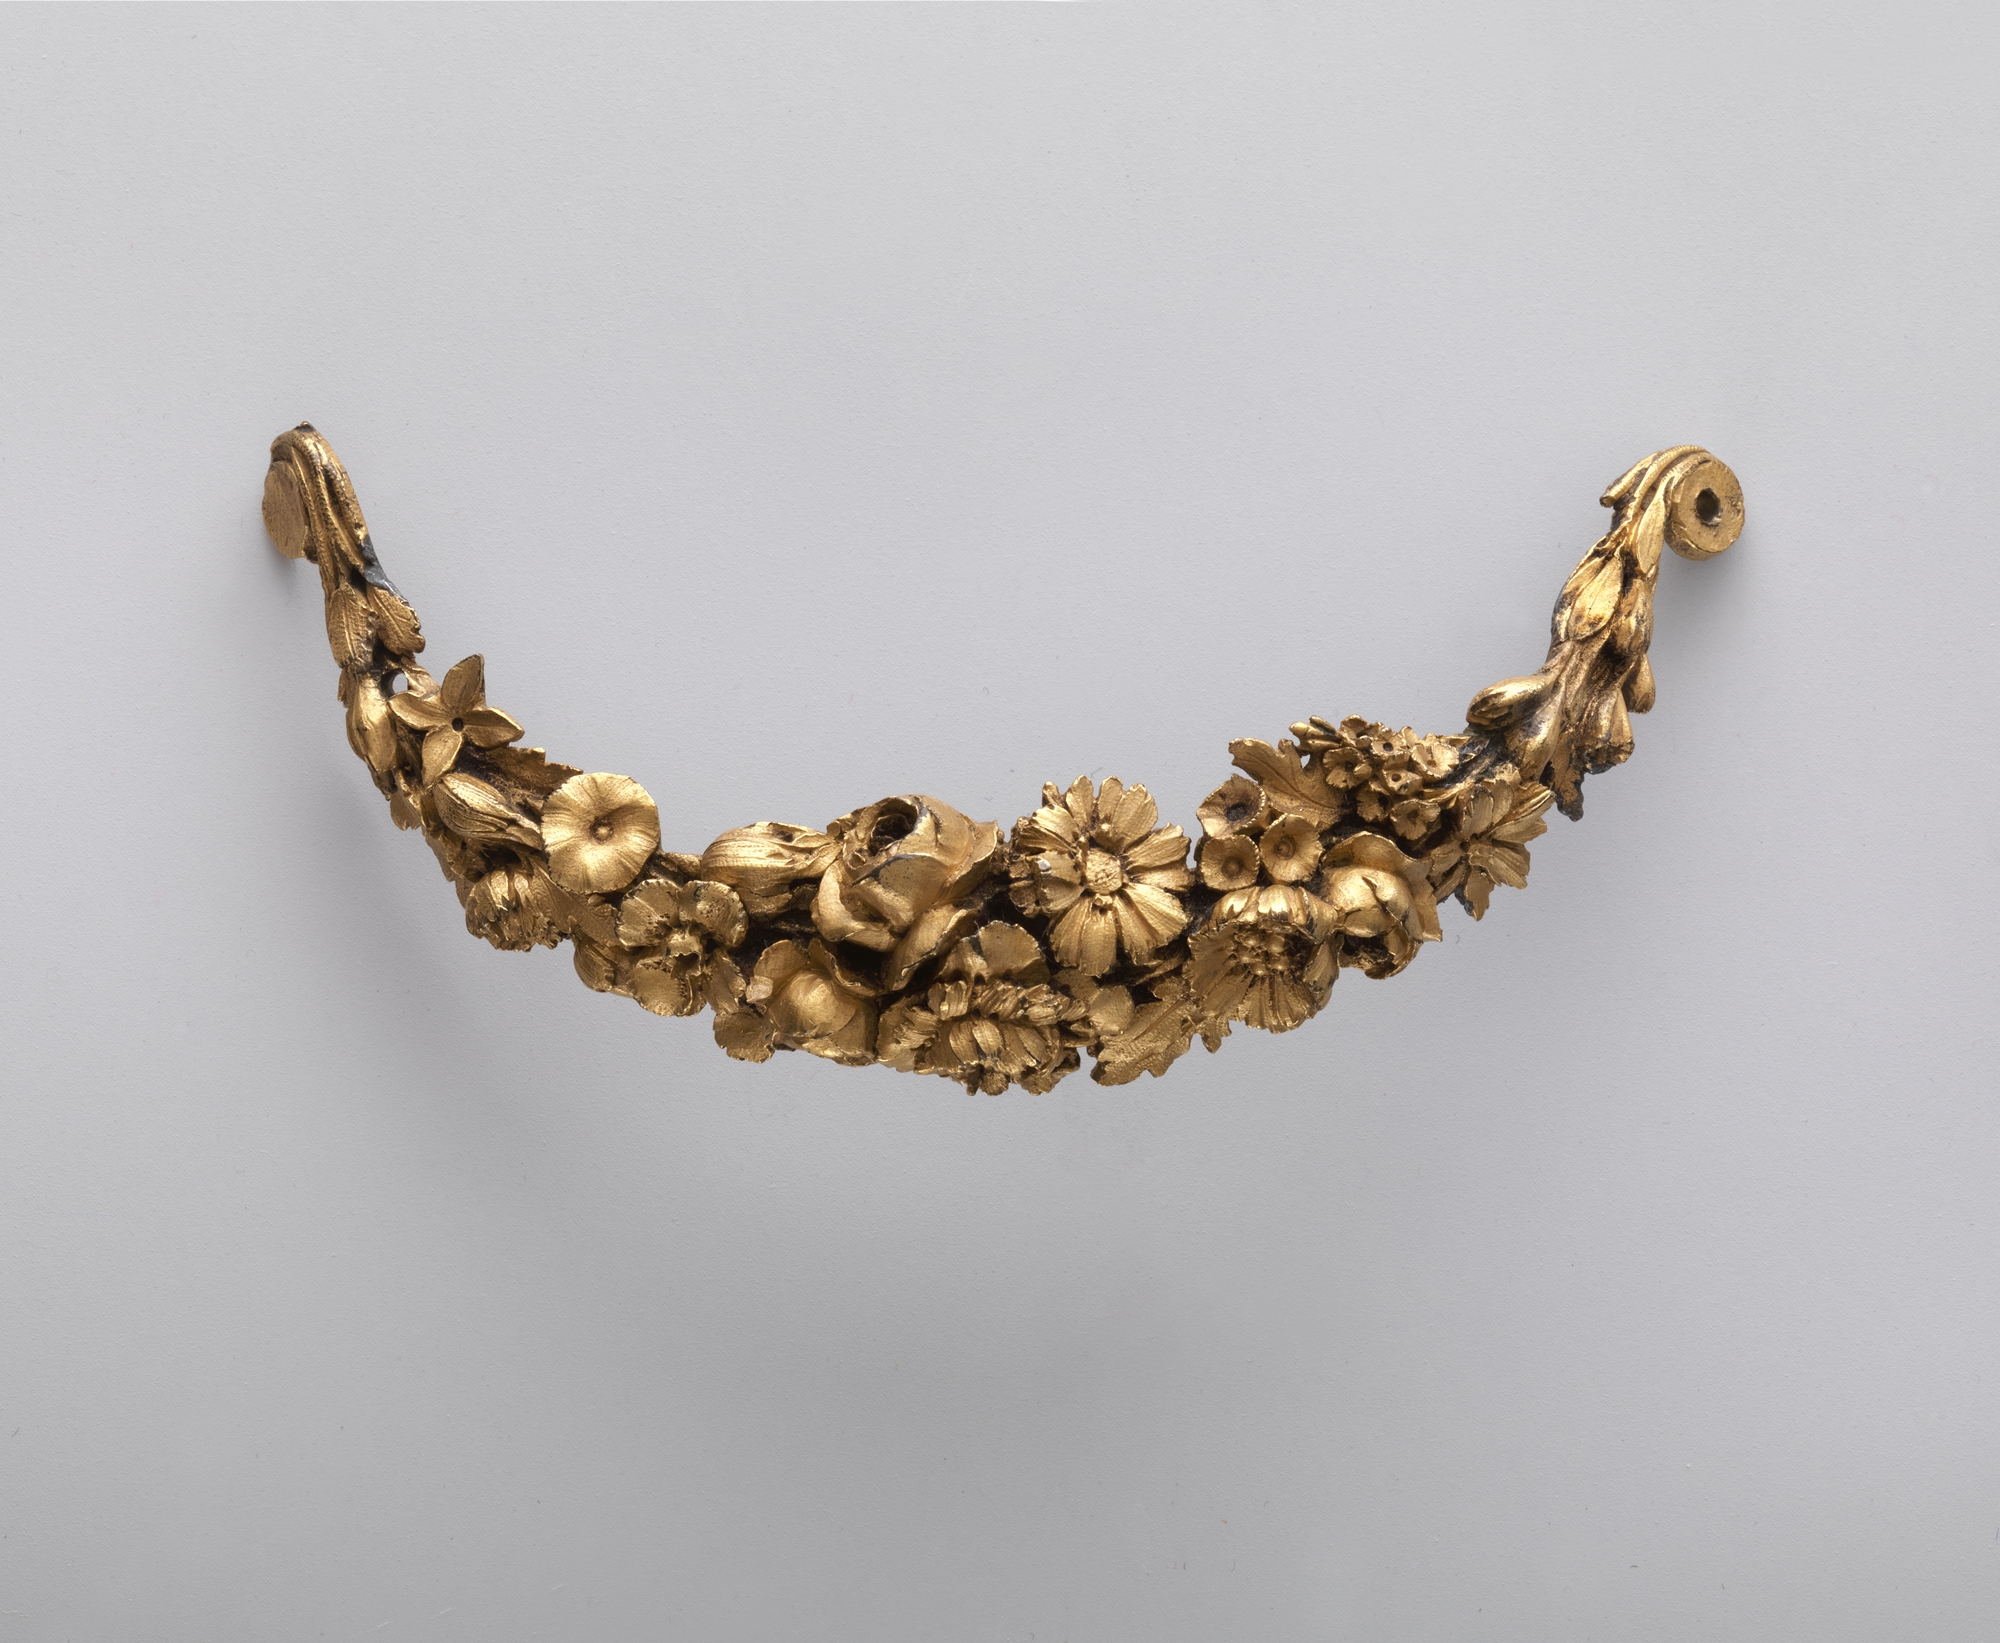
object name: swag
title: Pair of swags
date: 1701-1800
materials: gilt bronze